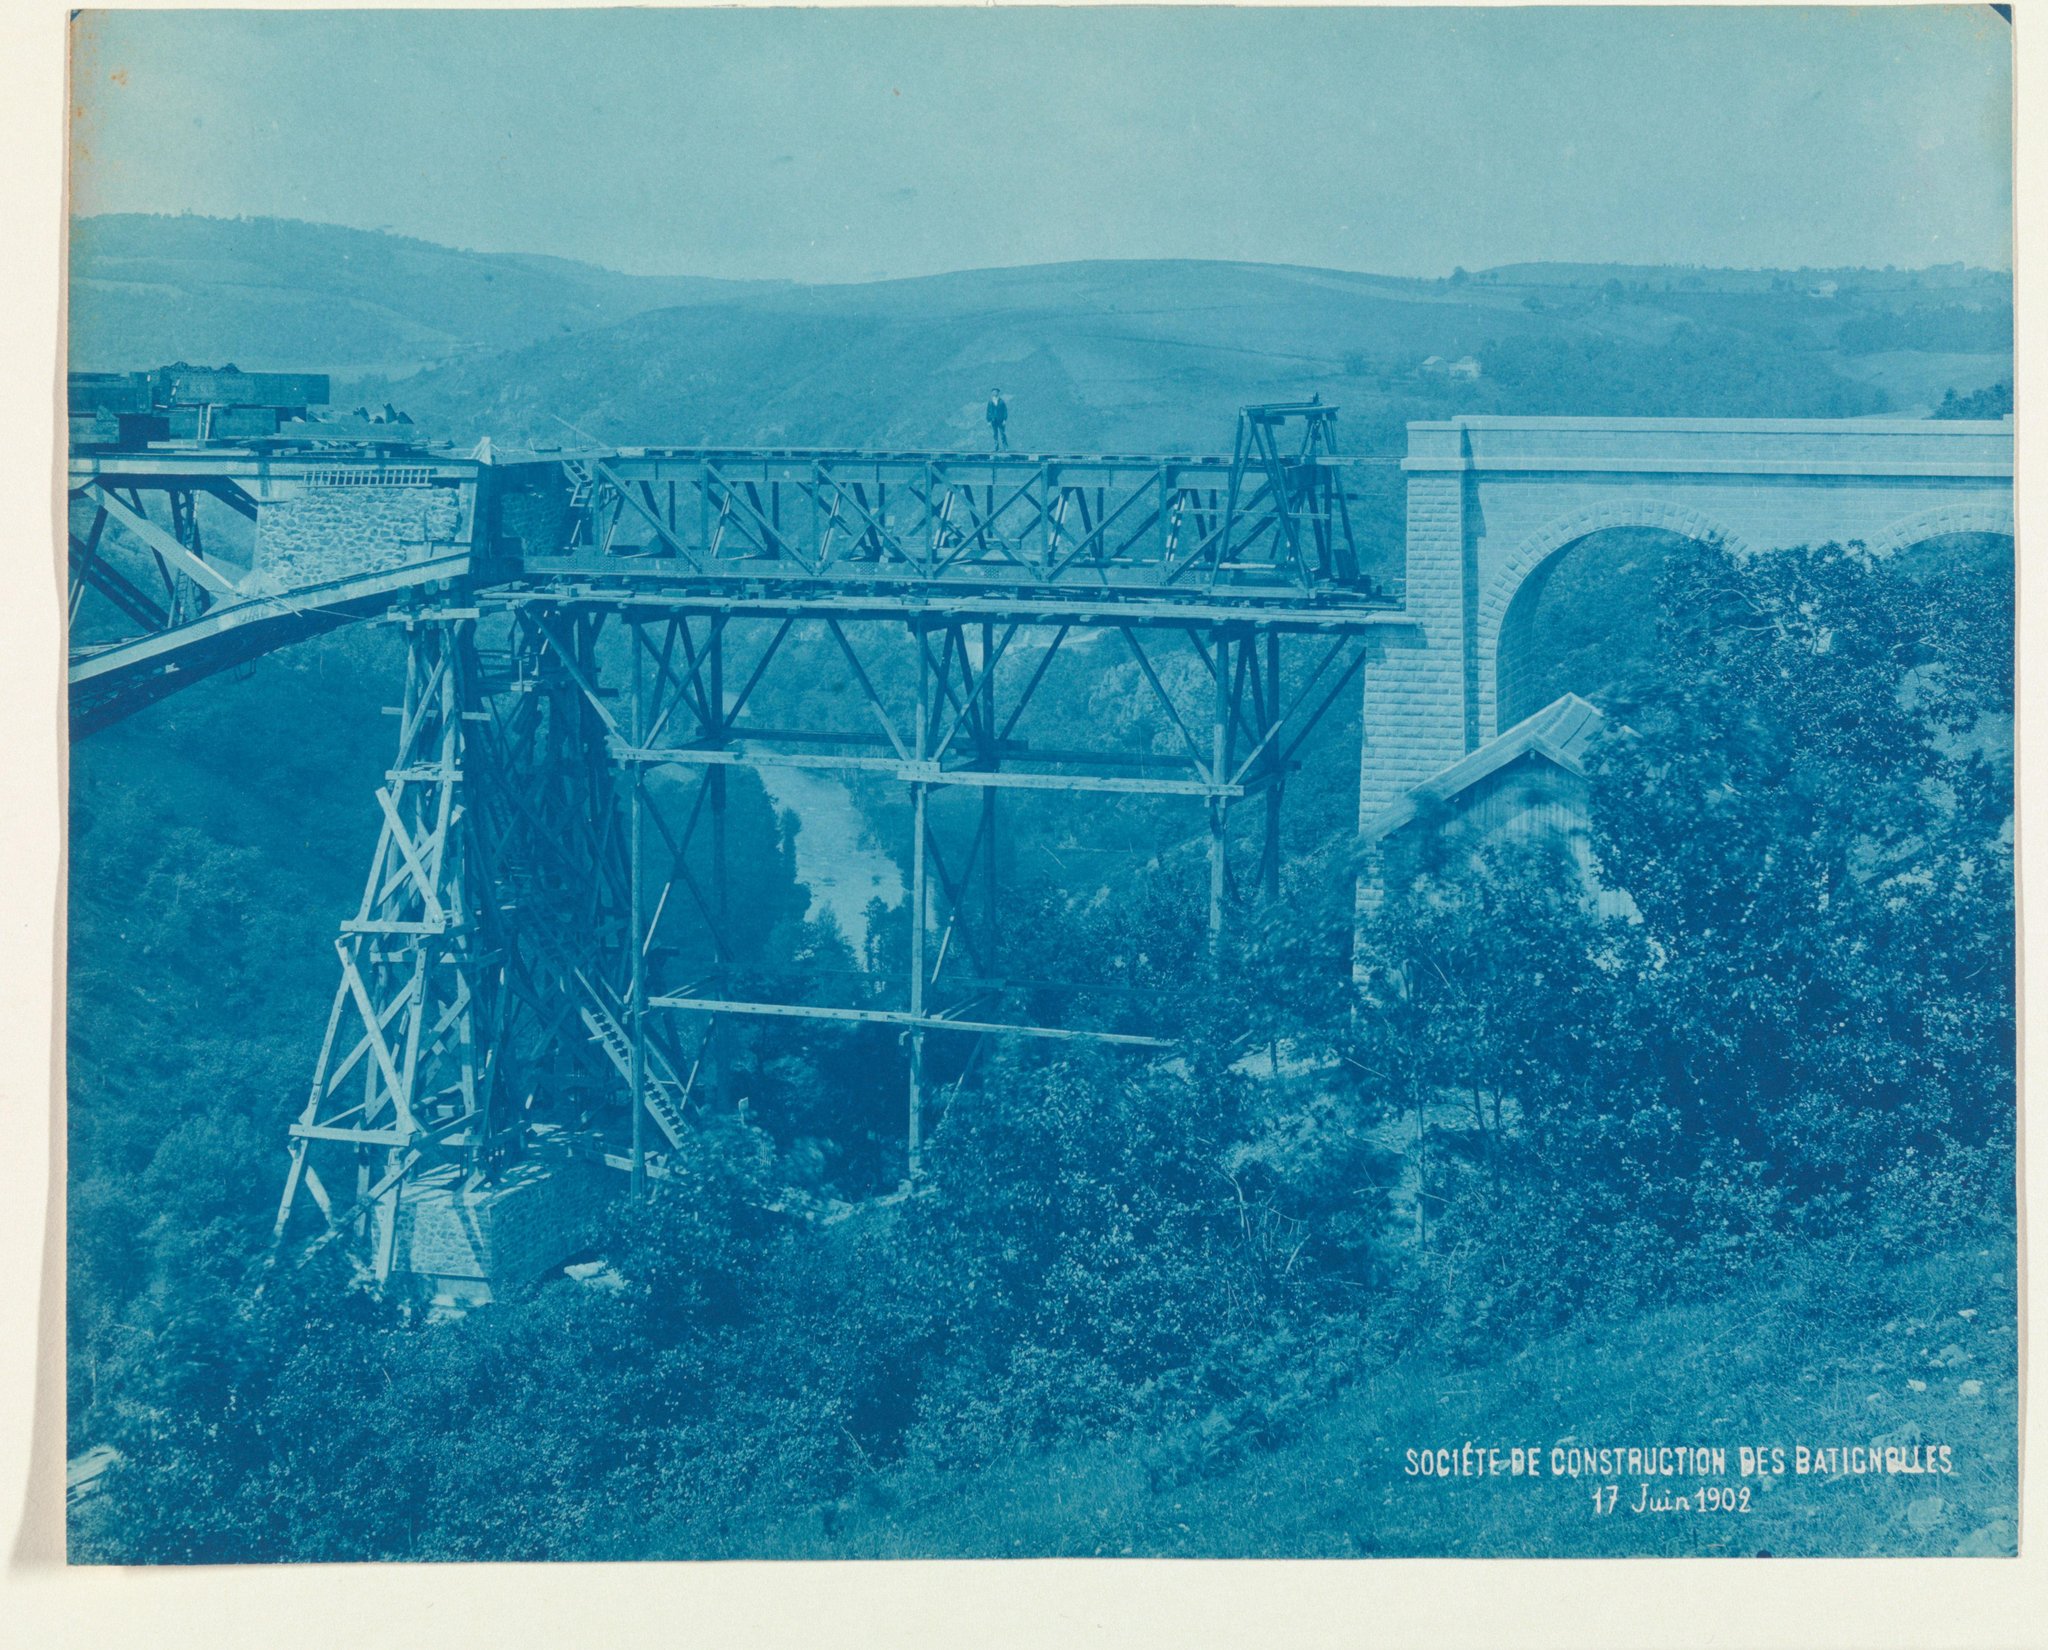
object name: photograph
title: Aanleg van het Viaur Viaduct in Frankrijk door de Societé de Construction des Battignolles, 17 juni 1902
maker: Anonymous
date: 1902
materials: photographic support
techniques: cyanotype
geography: france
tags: viaduct, making the overground structures (~ building activities)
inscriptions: name: ‘SOCIETÉ DE CONSTRUCTION DES BATOGNOLLES // 17 juin 1902’, inscription: ‘Travée de raccordement Roder // avec chariot de montage // Ancrage de l'encorbellement // Viaduc sur le Viaur’